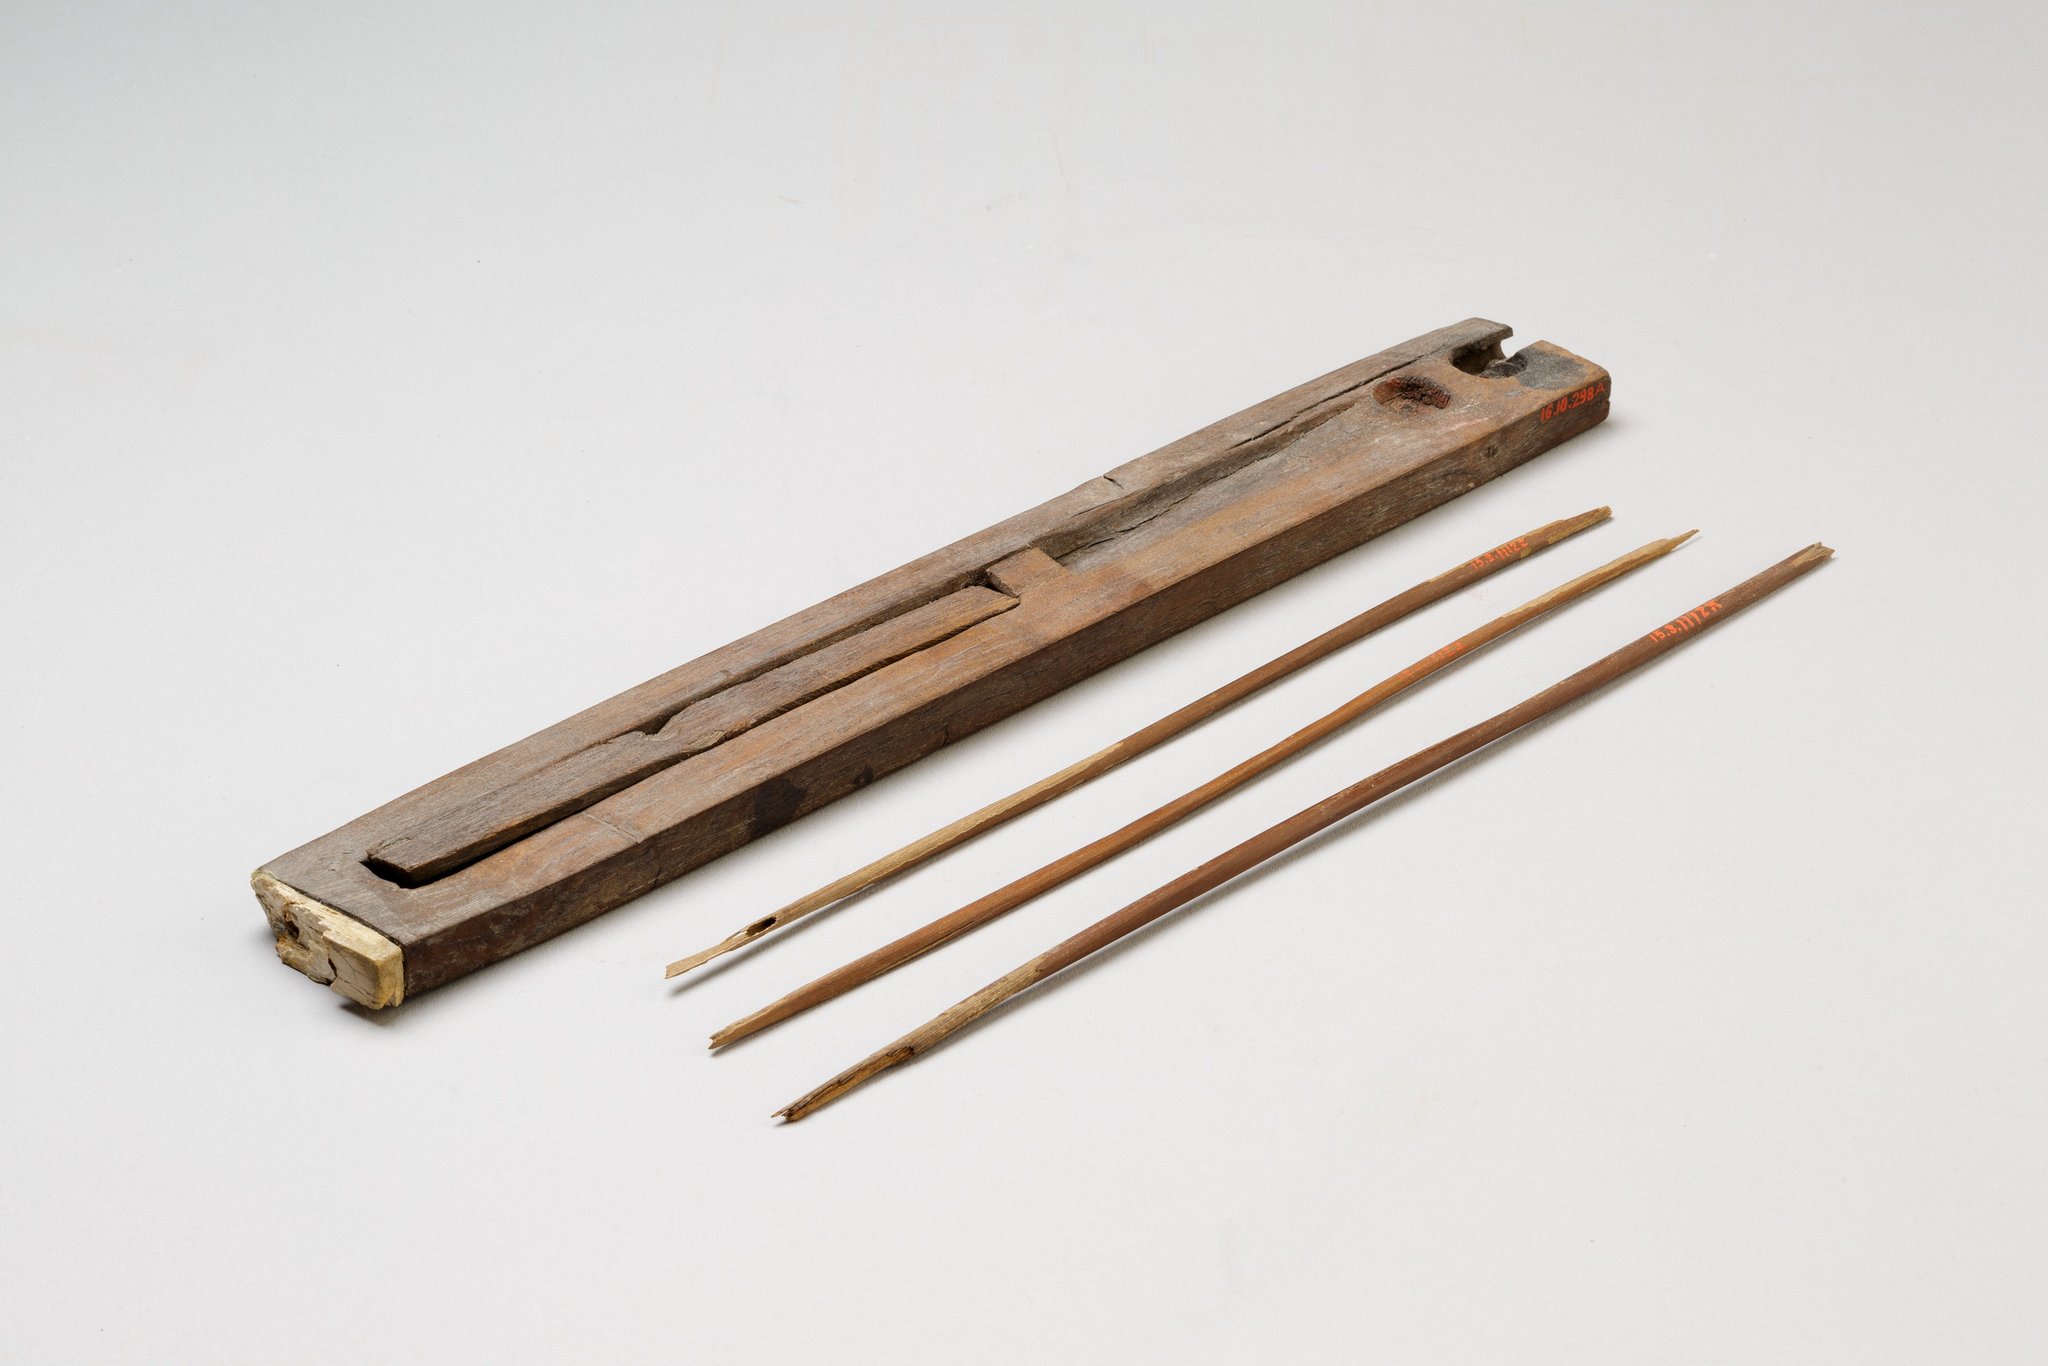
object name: scribal palette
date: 1635-1458 BCE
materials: ink, ivory, wood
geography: egypt